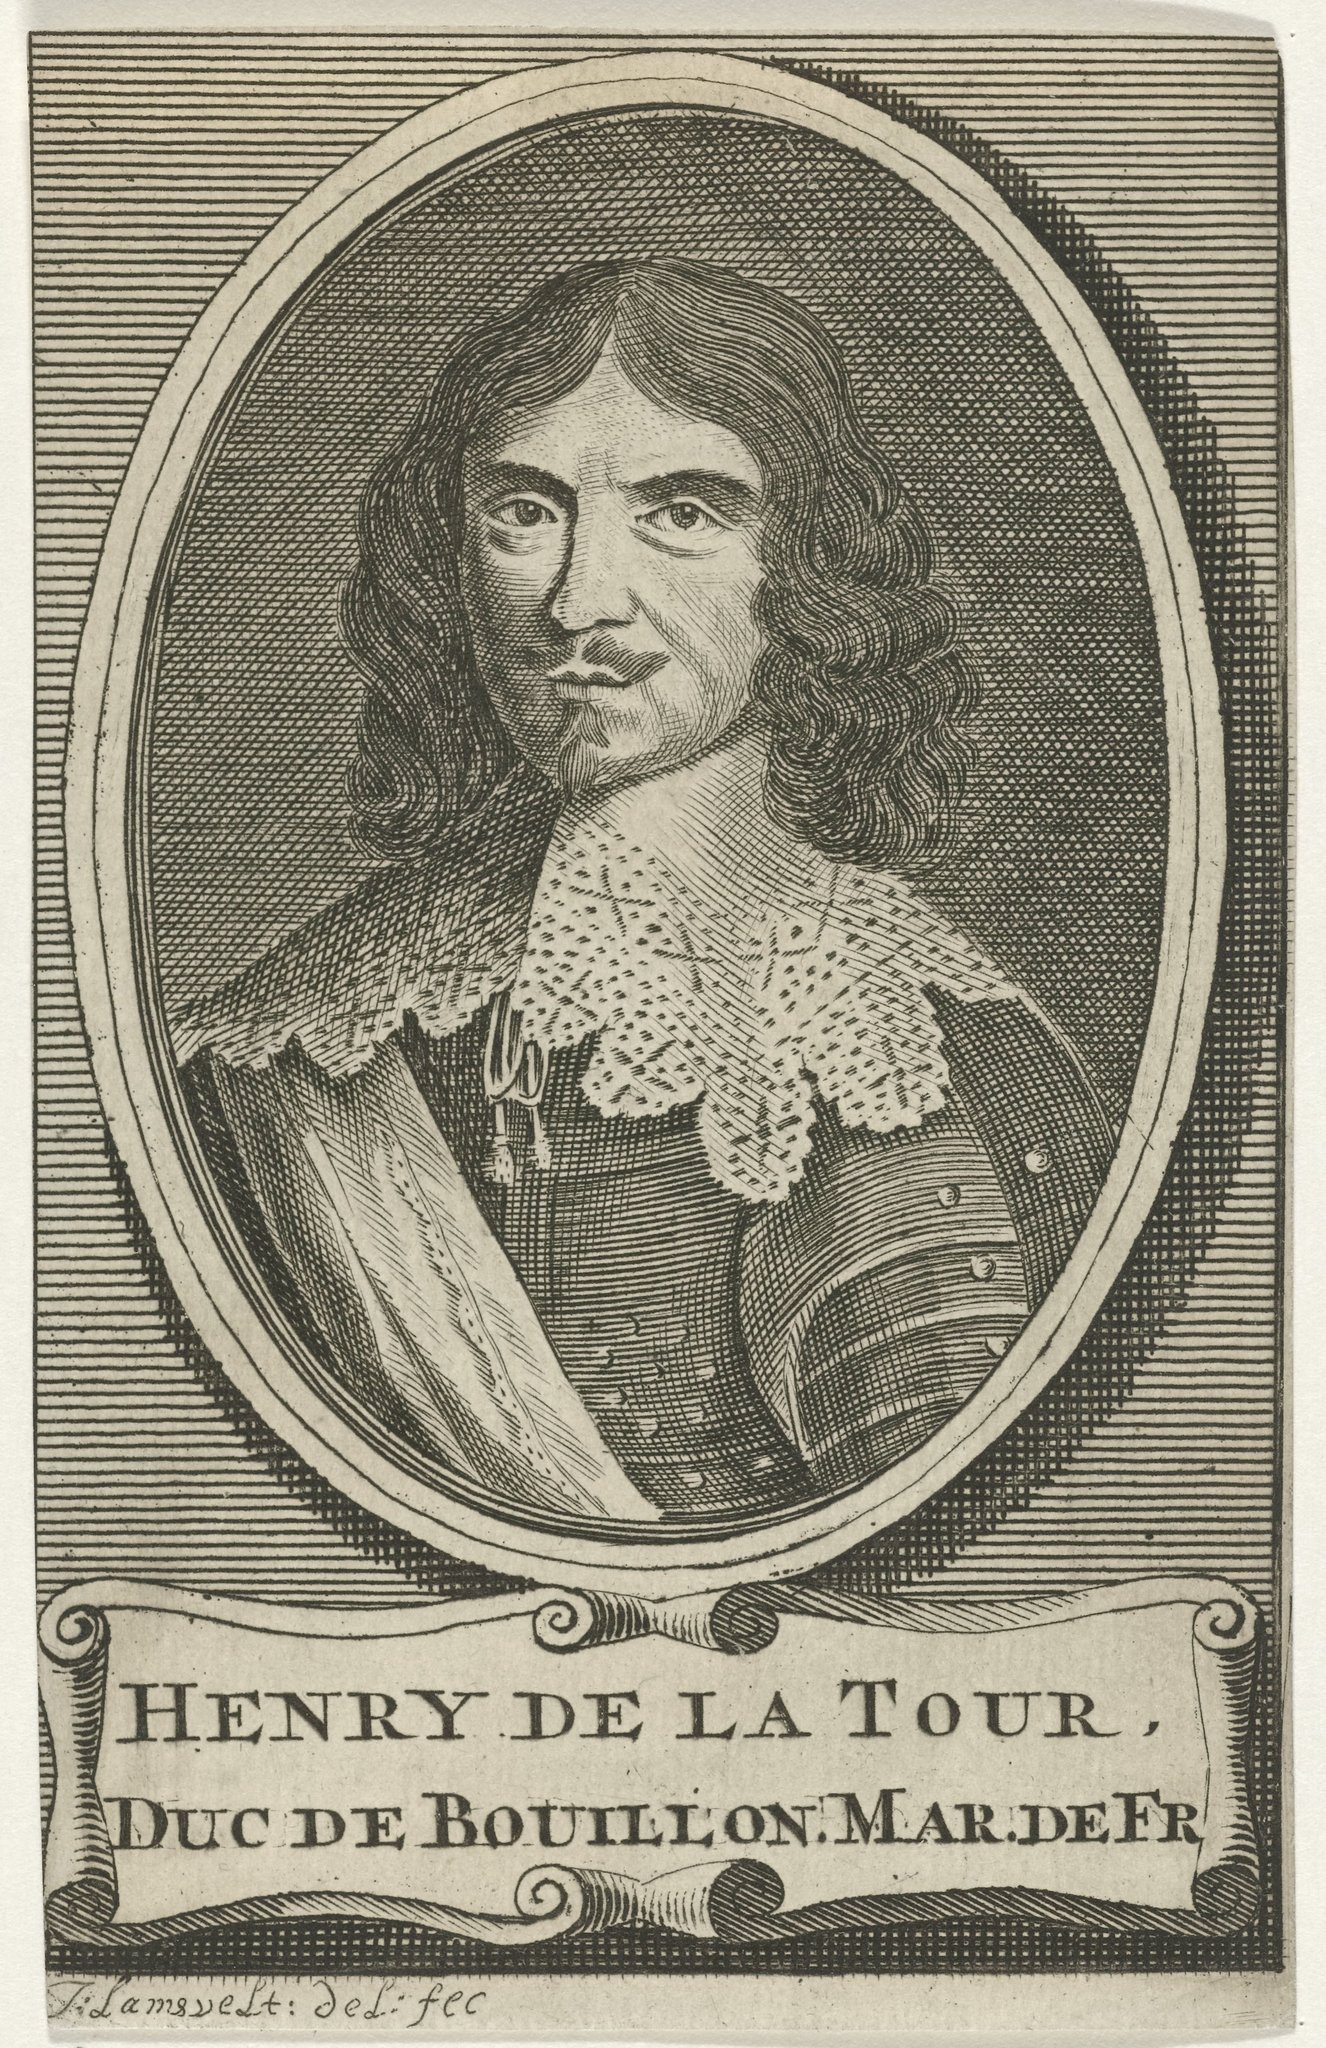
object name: print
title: Henry de la Tour, duc de Bouillon. Mar. de Fr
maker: jan lamsvelt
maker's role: print maker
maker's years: 1674-1743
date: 1684-1743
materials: paper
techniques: engraving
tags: sedan, hendrik van bouillon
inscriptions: collector's mark: Lugt 2228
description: Portretbuste in ovaal naar links van de Franse edelman Hendrik van Bouillon, blootshoofds en gehuld in een harnas. Onder het portret staan de naam en titels van de geportretteerde.